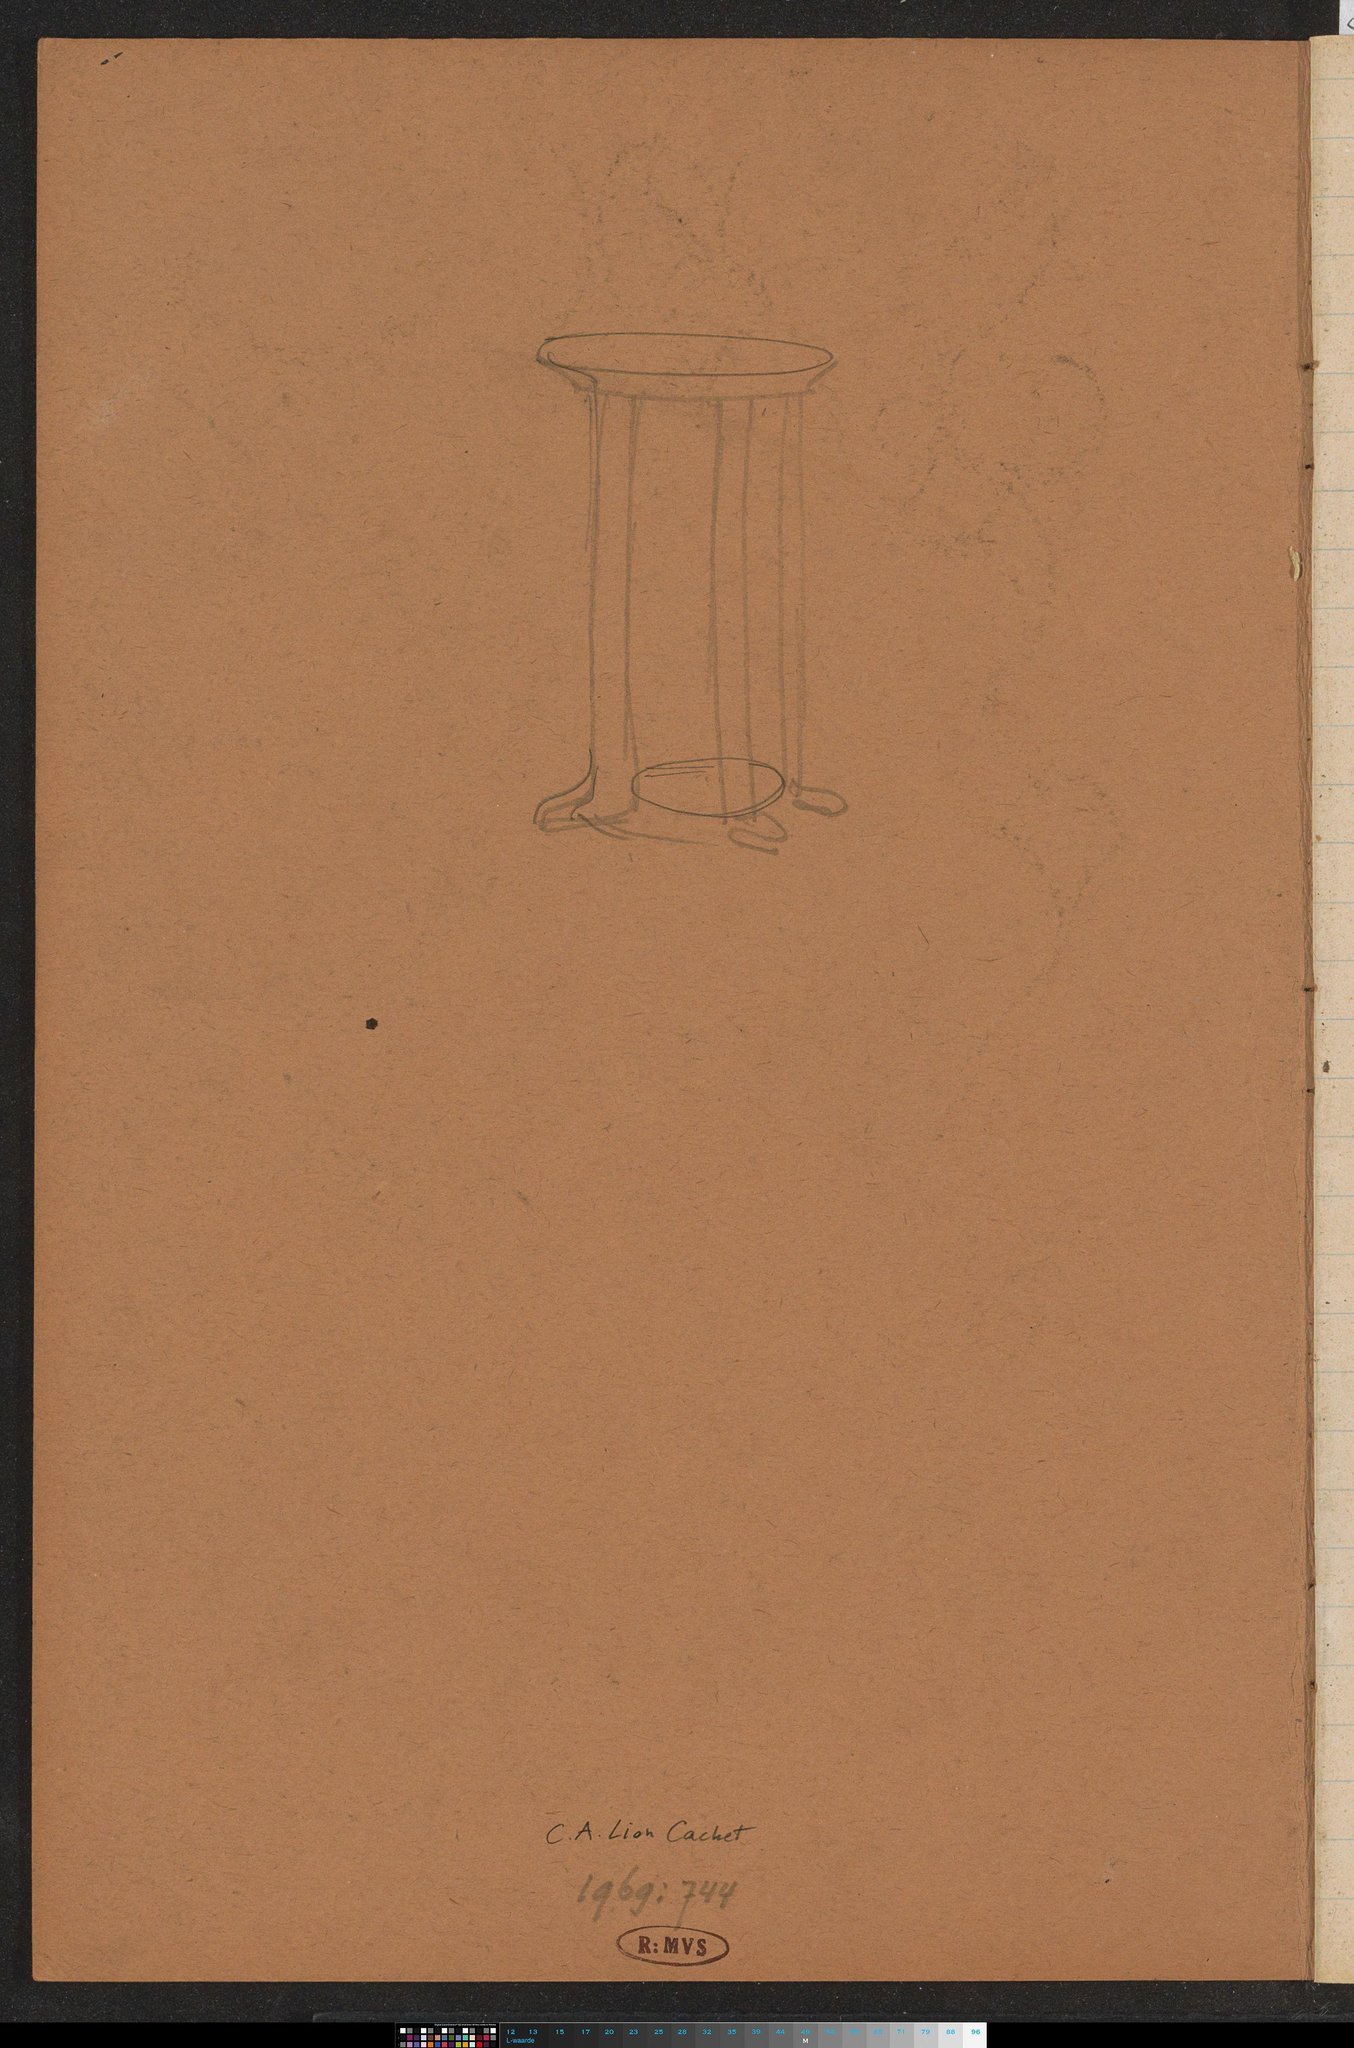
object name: endleaf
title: Ronde tafel met drie poten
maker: carel adolph lion cachet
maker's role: draughtsman, print maker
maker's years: 1864-1945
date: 1925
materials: pencil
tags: table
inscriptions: collector's mark: Lugt 2228a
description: Voorste schutblad uit een schetsboek met 11 bladen.